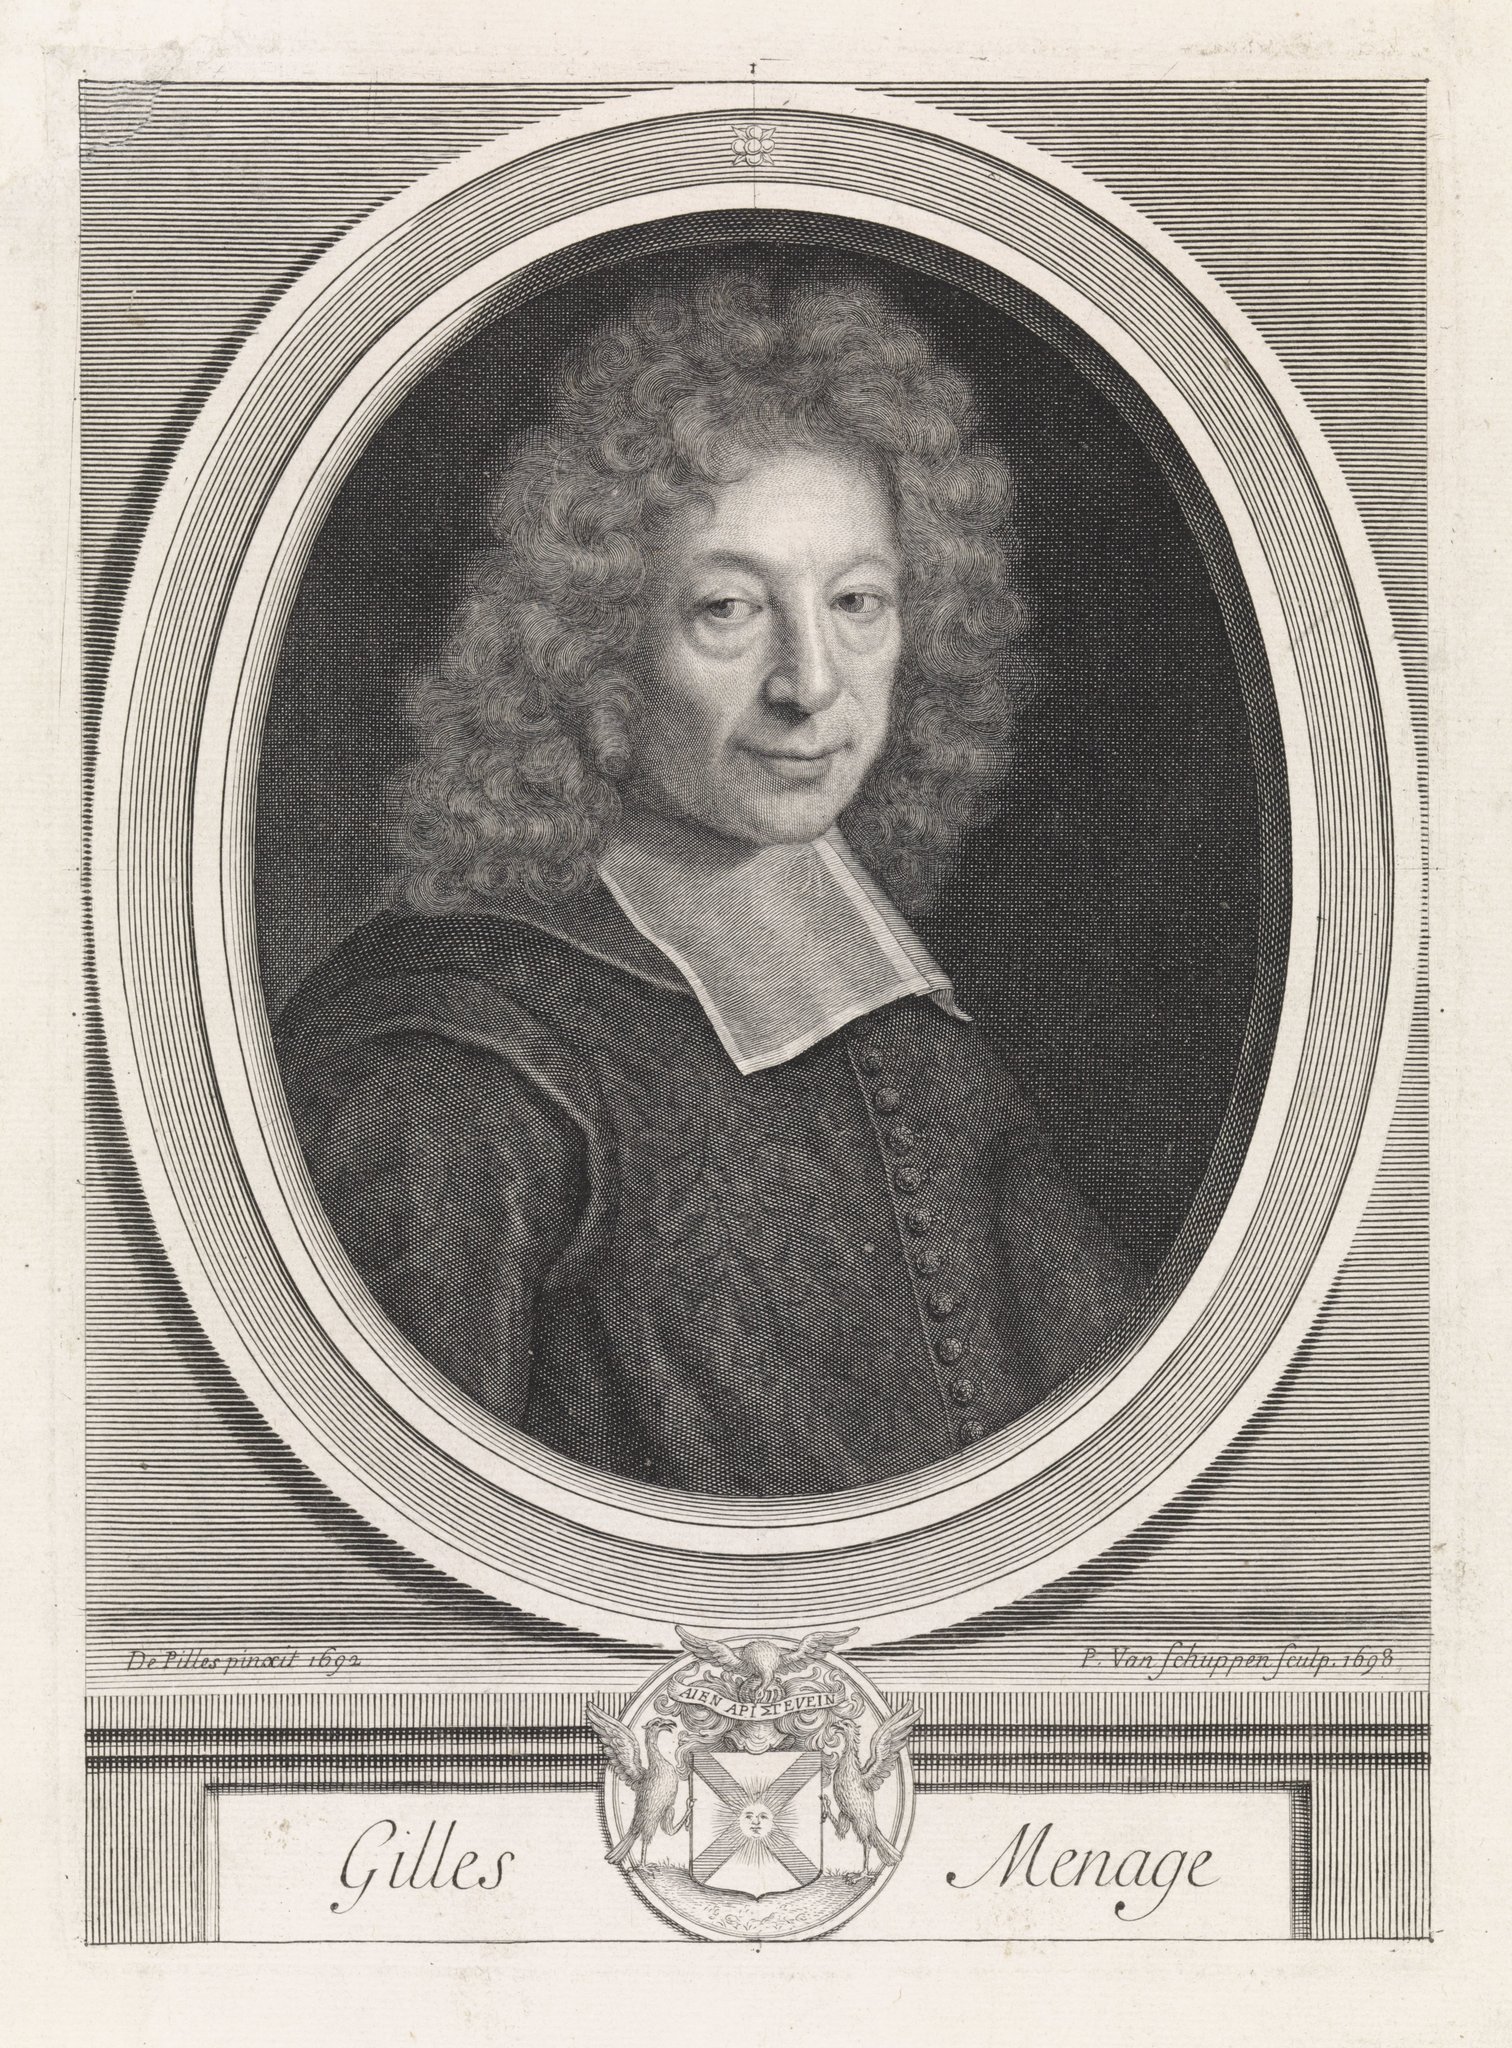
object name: print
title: Portret van Gilles Ménage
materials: paper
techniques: engraving, etching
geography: paris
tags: paris, gilles ménage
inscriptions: collector's mark: Lugt 2228